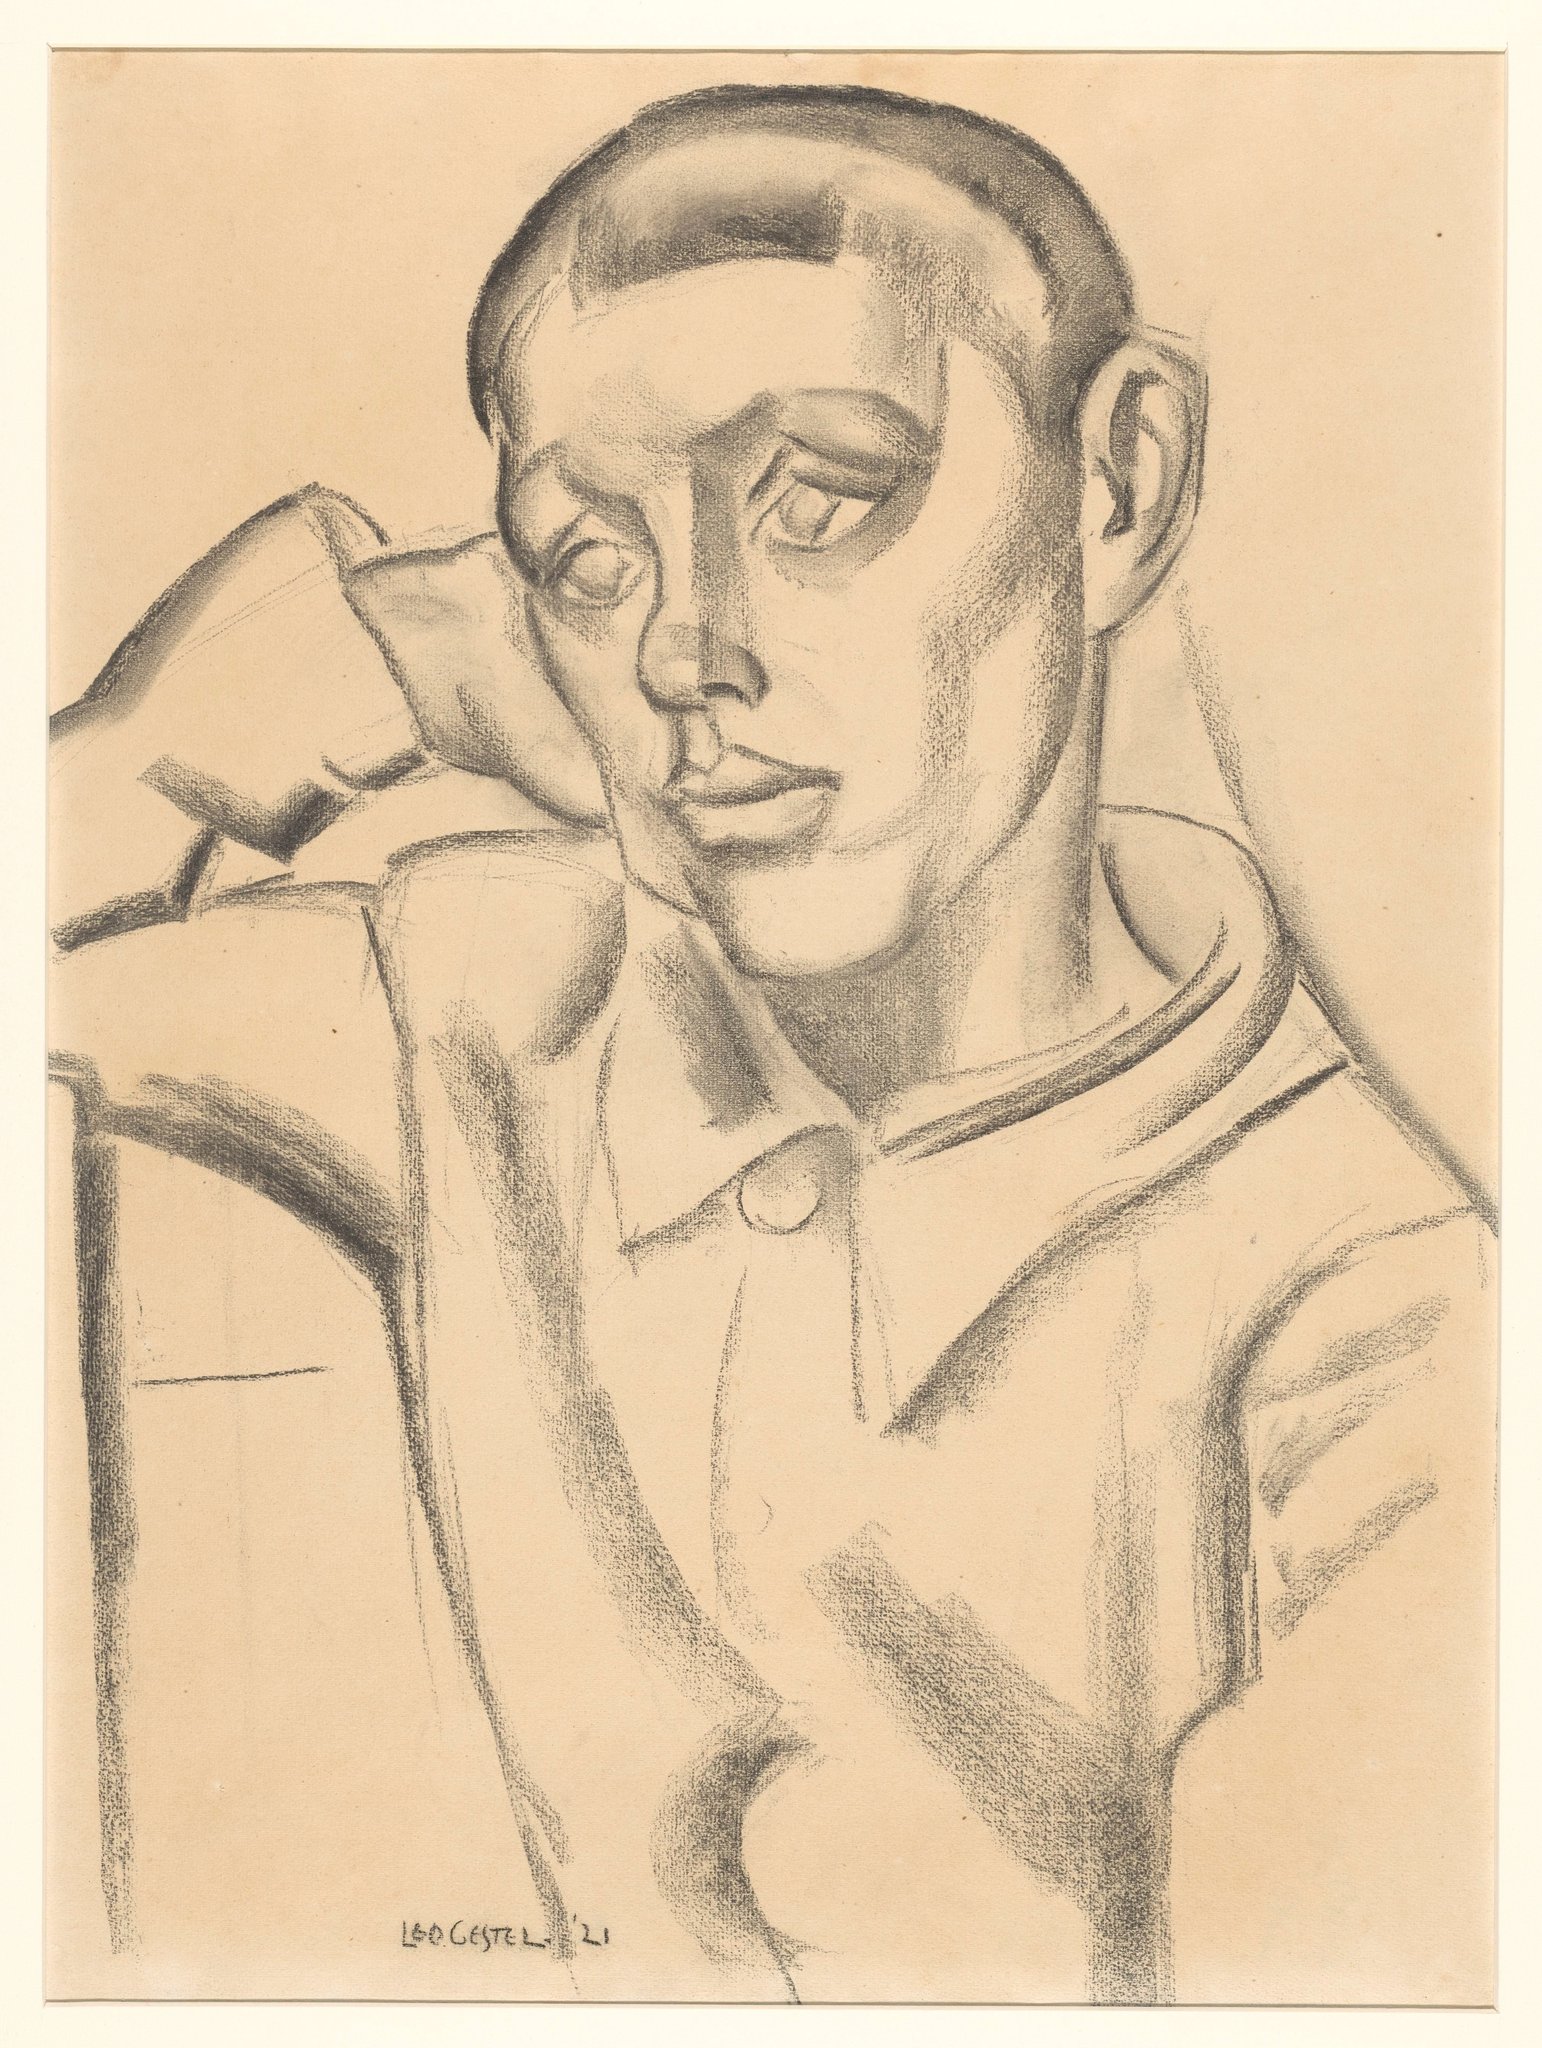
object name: drawing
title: Jonge man steunt zijn hoofd op zijn hand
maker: leo gestel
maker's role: draughtsman, print maker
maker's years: 1881-1941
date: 1921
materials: charcoal, paper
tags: anonymous historical person portrayed alone